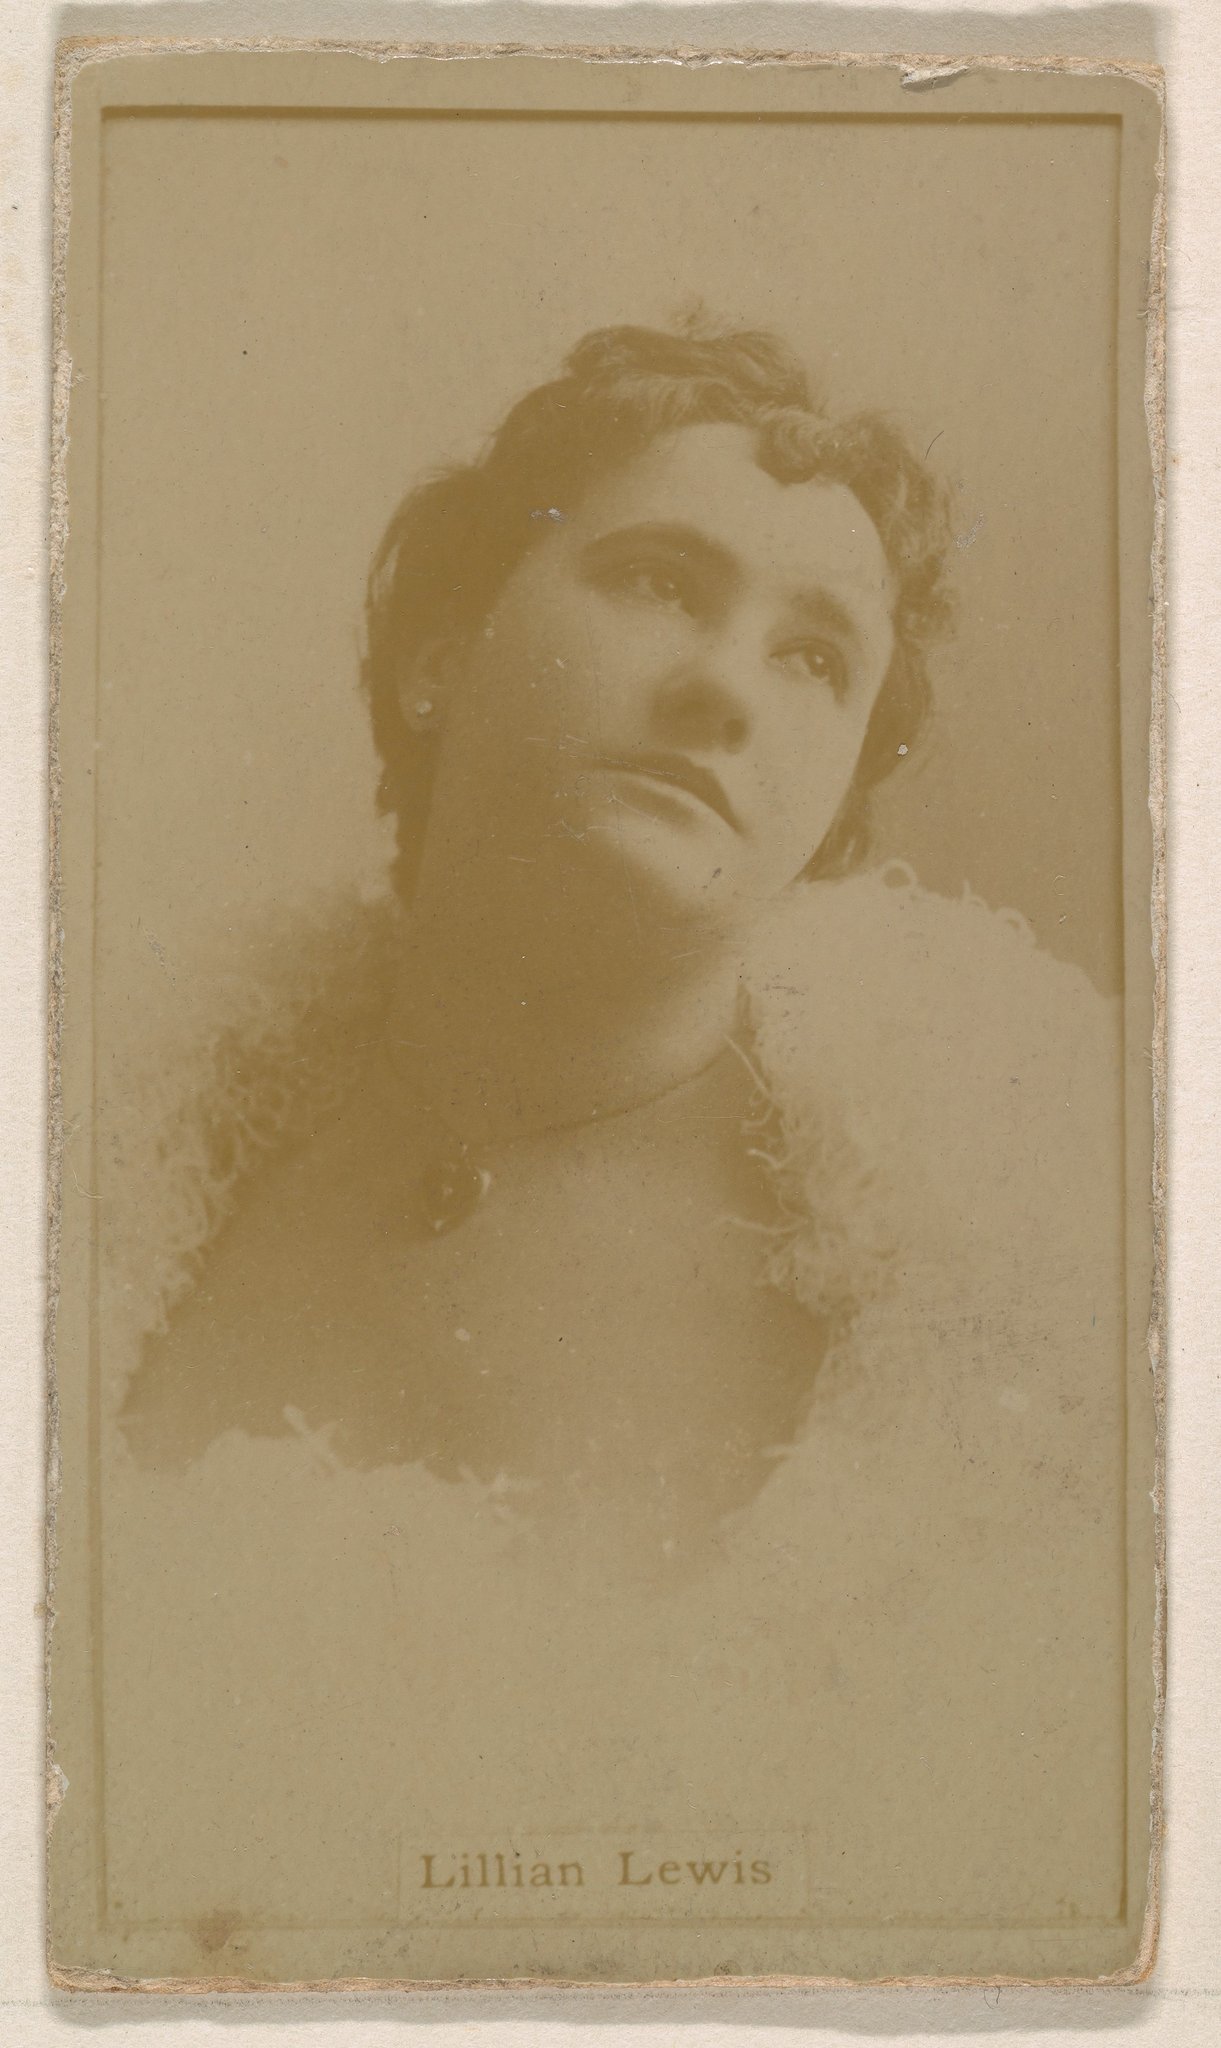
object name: photograph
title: Lillian Lewis, from the Actresses series (N245) issued by Kinney Brothers to promote Sweet Caporal Cigarettes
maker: kinney brothers tobacco company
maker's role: publisher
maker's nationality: american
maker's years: 1869-2011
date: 1890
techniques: albumen silver print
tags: portraits,women,actresses